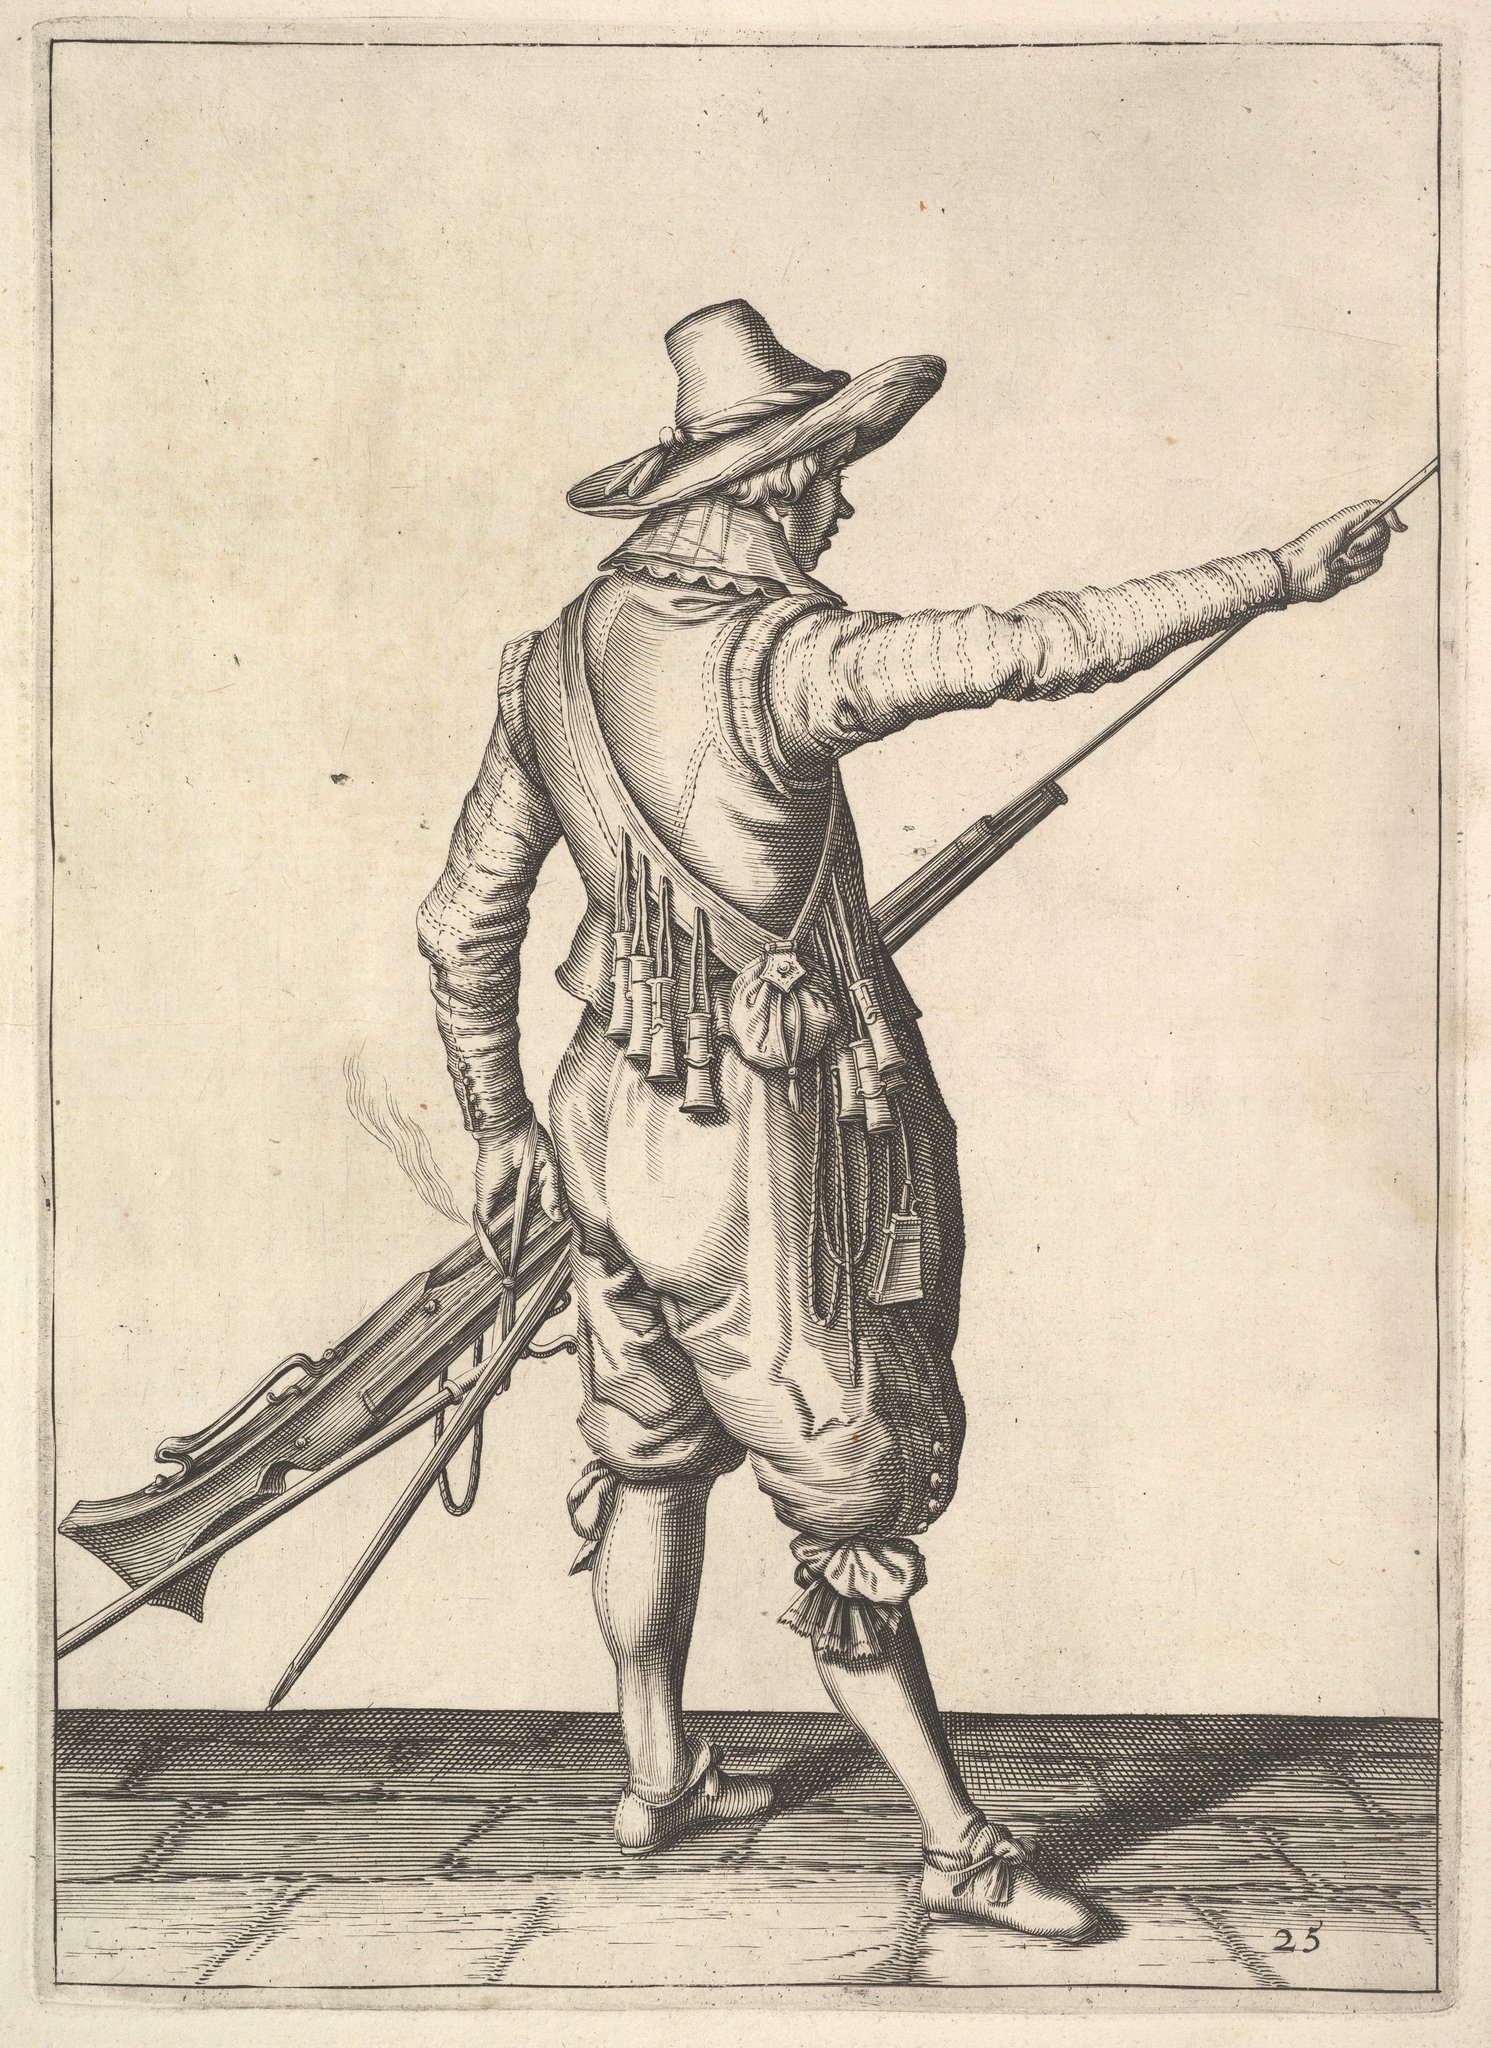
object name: print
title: A soldier pulling out the ramrod from its holder, from the Musketeers series, plate 25, in "Wapenhandelinghe van Roers Musquetten Ende Spiessen" (The Exercise of Arms)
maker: jacques de gheyn (ii)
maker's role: artist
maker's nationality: netherlandish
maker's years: 1565-1629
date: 1575-1629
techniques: engraving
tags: soldiers,firearms